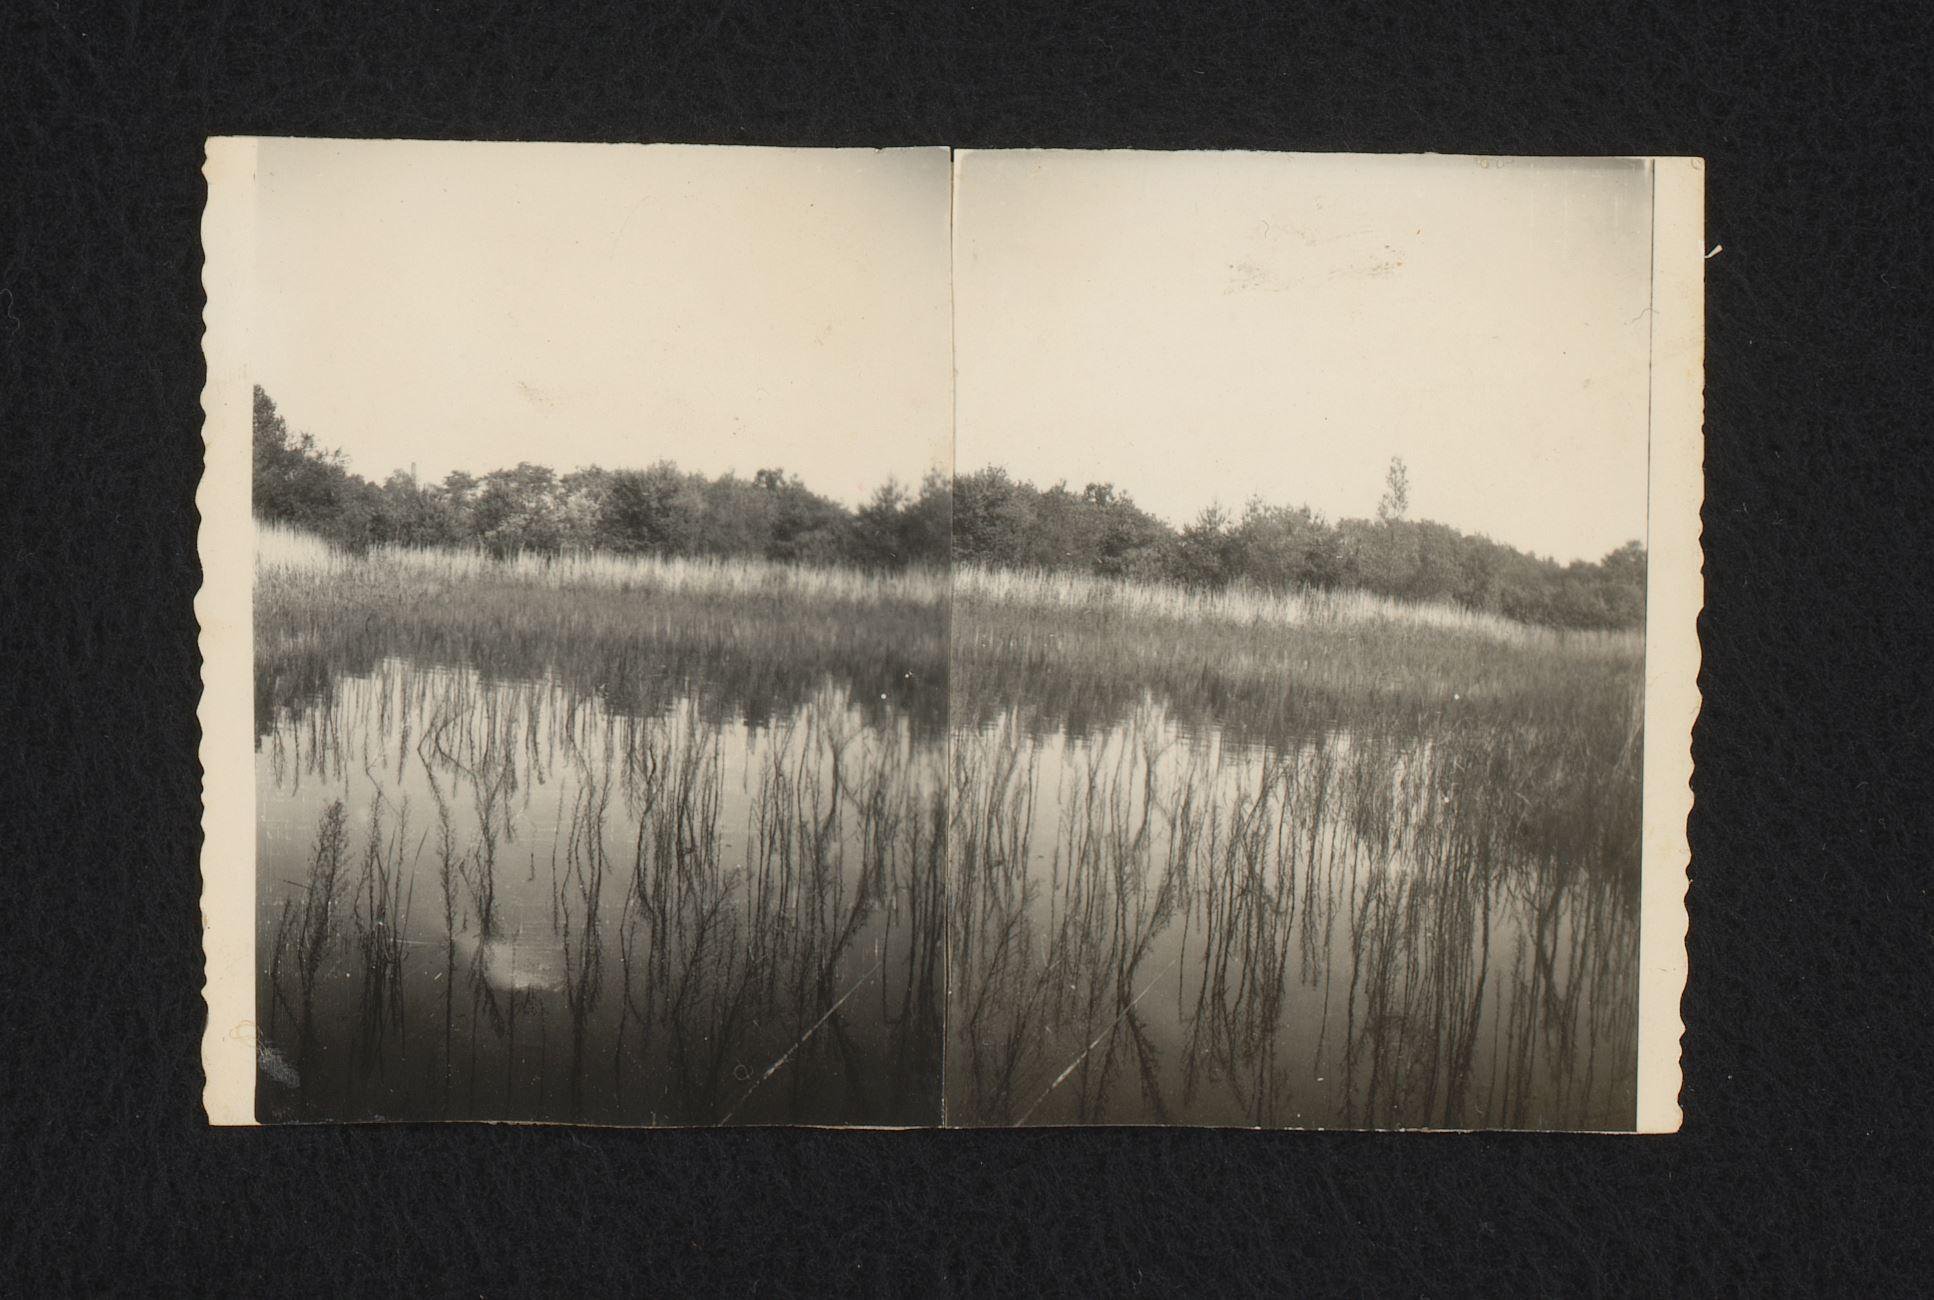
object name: photograph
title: Rietland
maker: Anonymous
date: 1940-1947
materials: photographic support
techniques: gelatin silver print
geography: netherlands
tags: swamp, inland marsh, fens, netherlands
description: Waterkant begroeid met riet. Losse foto in melinex-mapje achterin het Familiealbum 1940-1947.